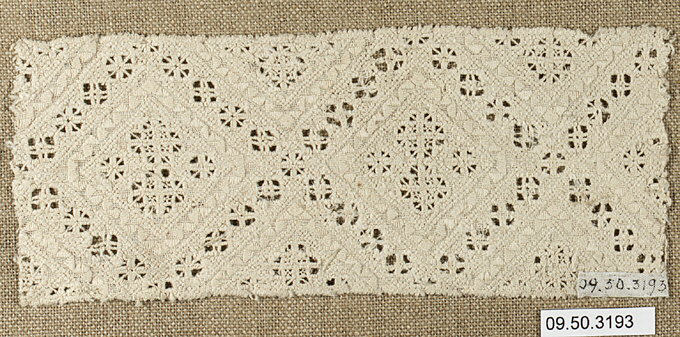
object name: fragment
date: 1701-1800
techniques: lace